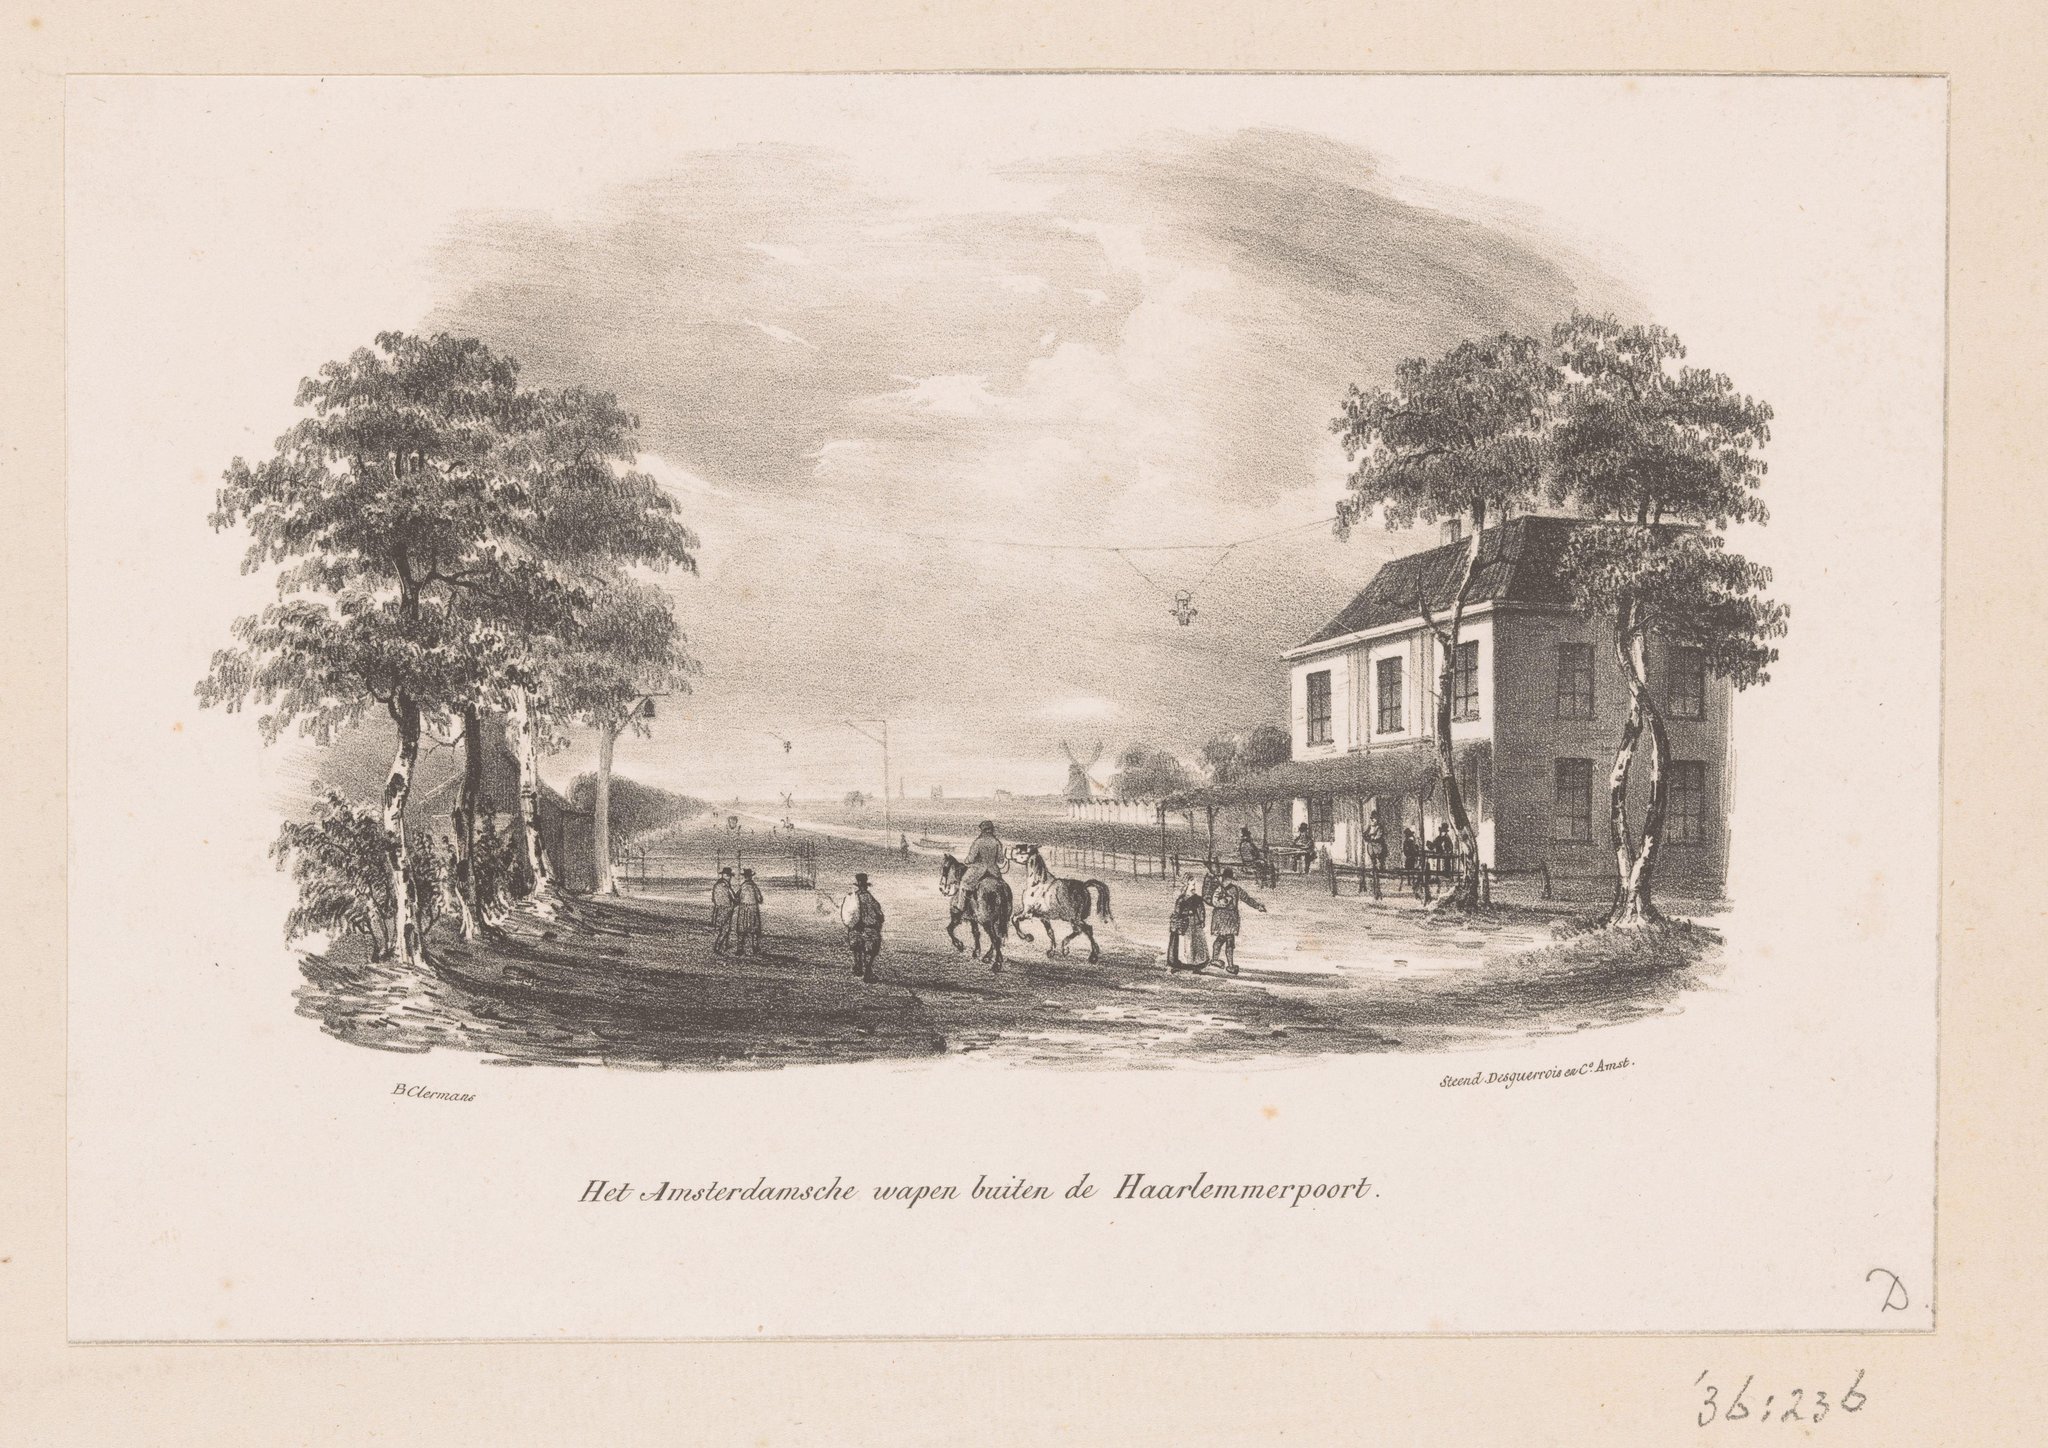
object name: print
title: Gezicht op herberg het Wapen van Amsterdam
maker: j.b. clermans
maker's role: print maker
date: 1826-1839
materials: paper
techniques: lithograph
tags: hotel, hostelry, inn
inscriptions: collector's mark: Lugt 2760, collector's mark: Lugt 2228, collector's mark: ‘HIST: TOPOGR: ATLAS [..]R [..]M: AMSTERDAM’